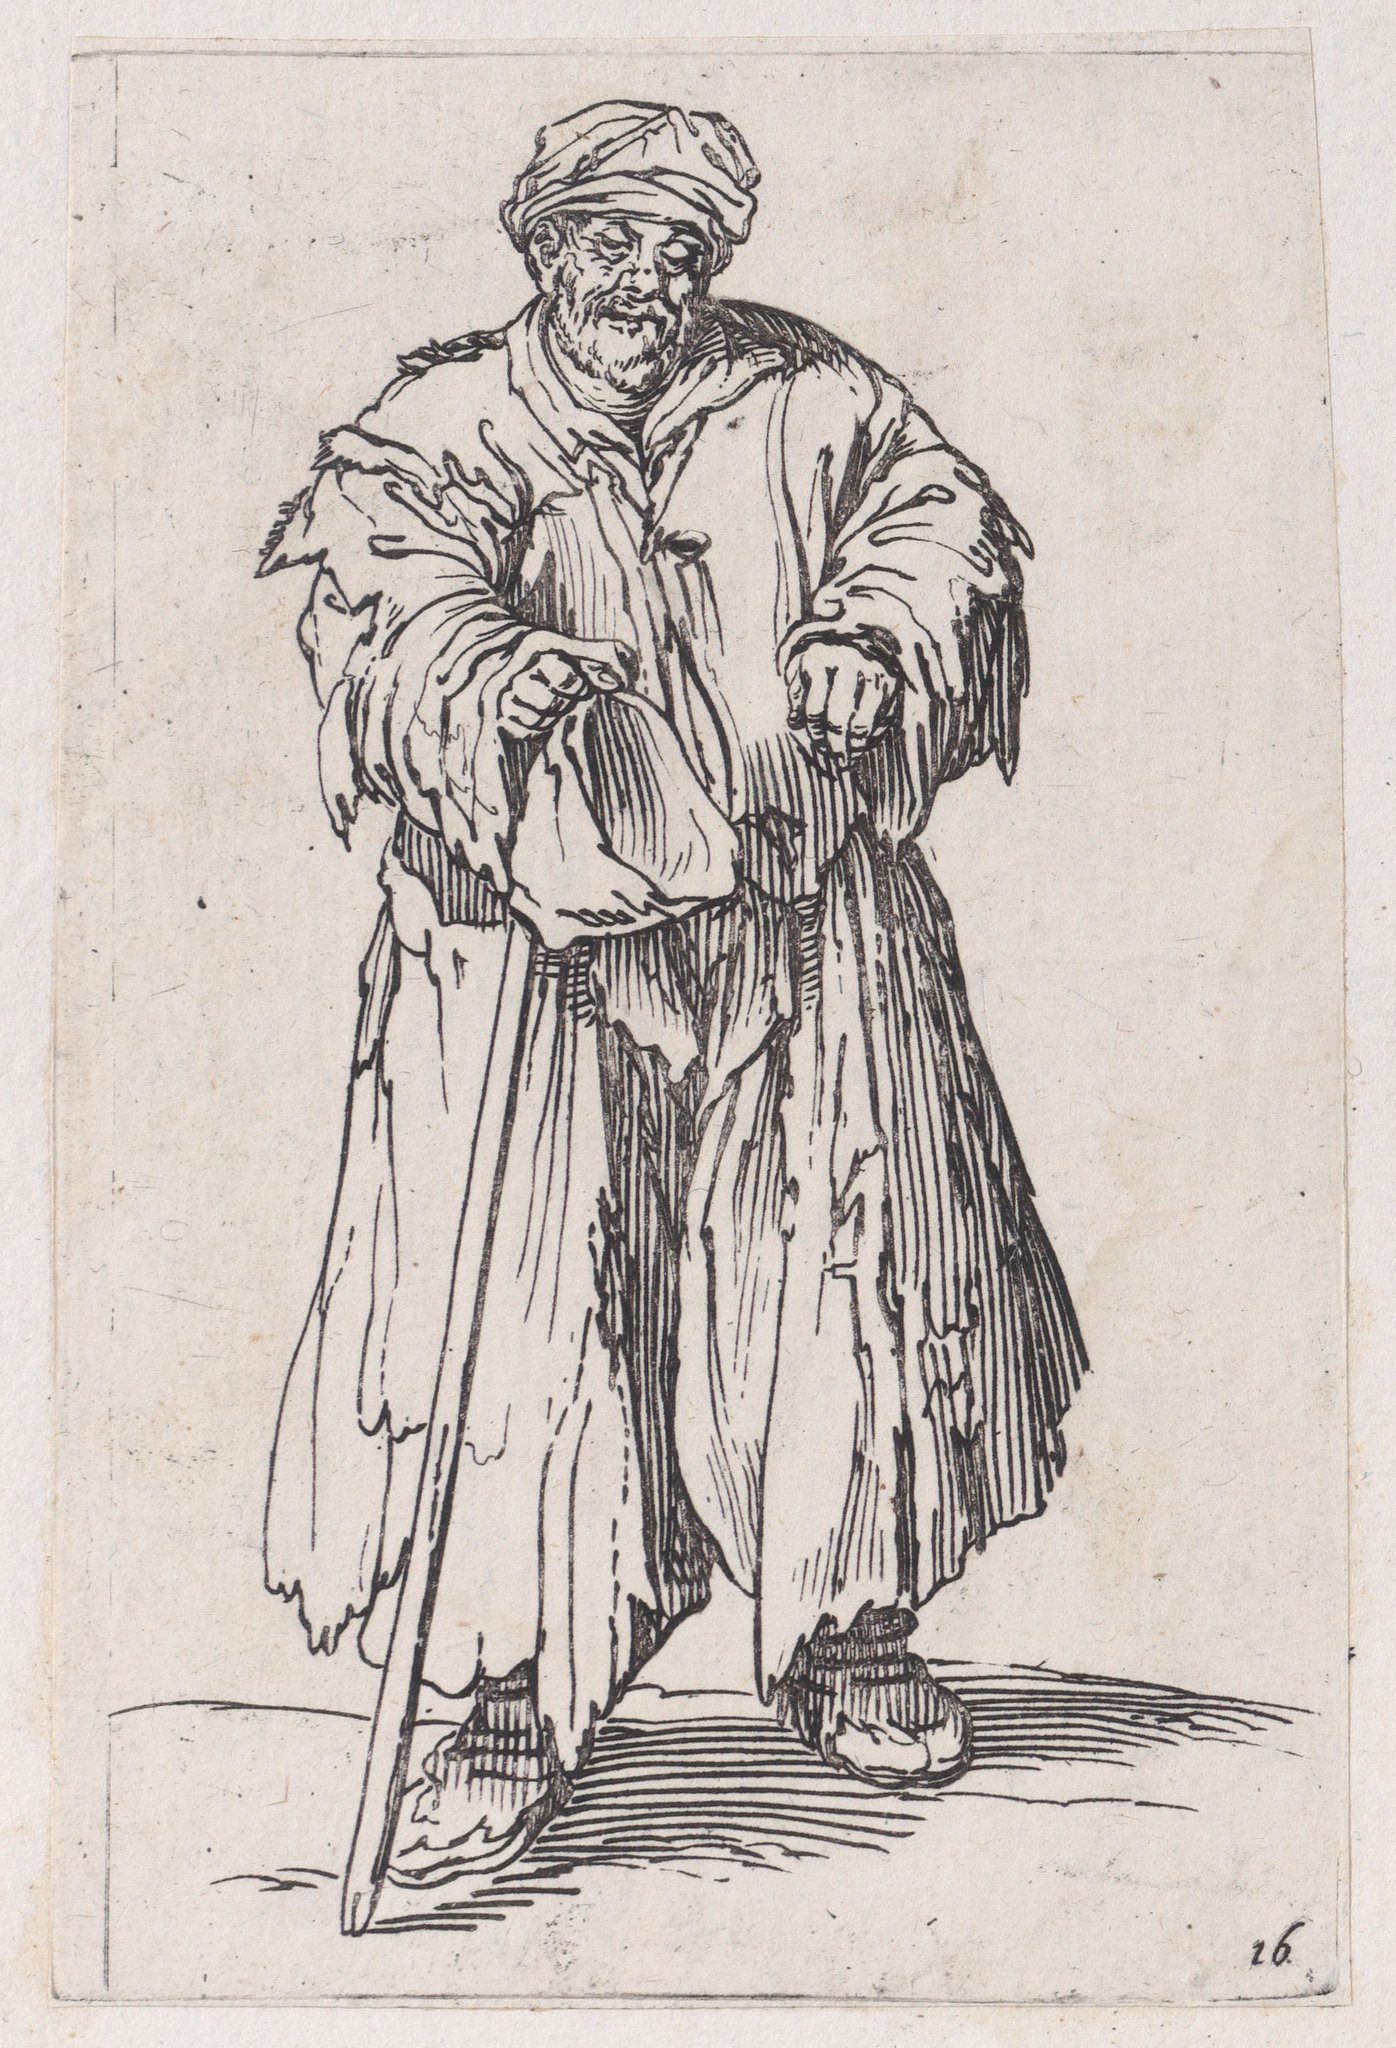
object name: print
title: Reverse Copy of Le Mendiant Obèse aux Yeux Baissés (The Obese Beggar with Lowered Eyes), from Les Gueux suite appelée aussi Les Mendiants, Les Baroni, ou Les Barons (The Beggars, also called the Barons)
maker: Anonymous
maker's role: artist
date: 1601-1700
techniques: etching